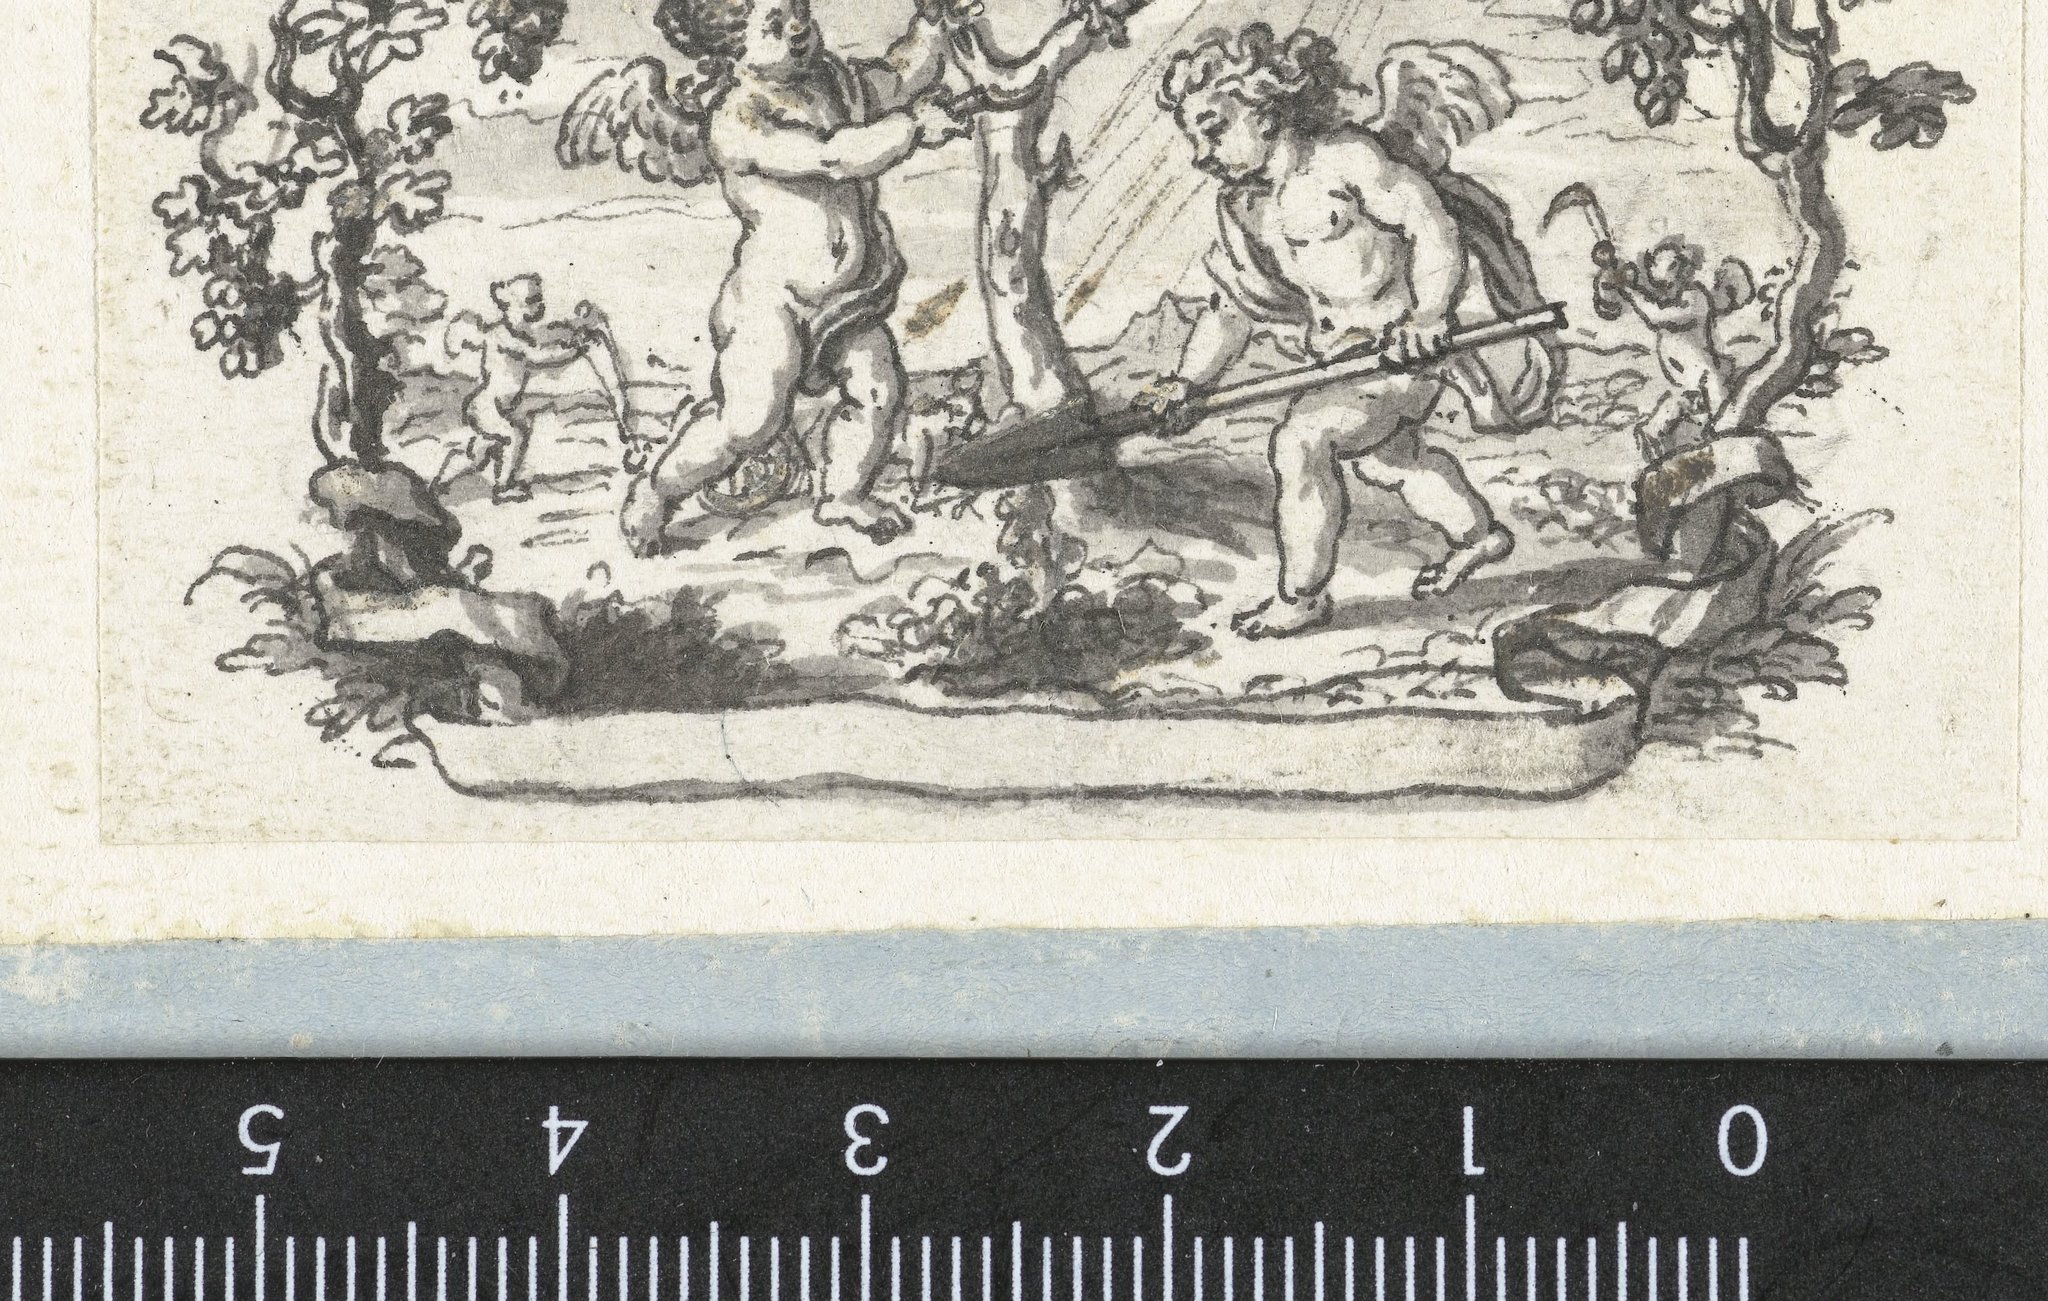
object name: design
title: Vignet met twee putti die een boom planten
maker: bernard picart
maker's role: draughtsman, print maker, publisher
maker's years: 1673-1733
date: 1683-1733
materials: ink, paper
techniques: brush, pen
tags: transplanting, setting out plants, trees (+ plants used symbolically)